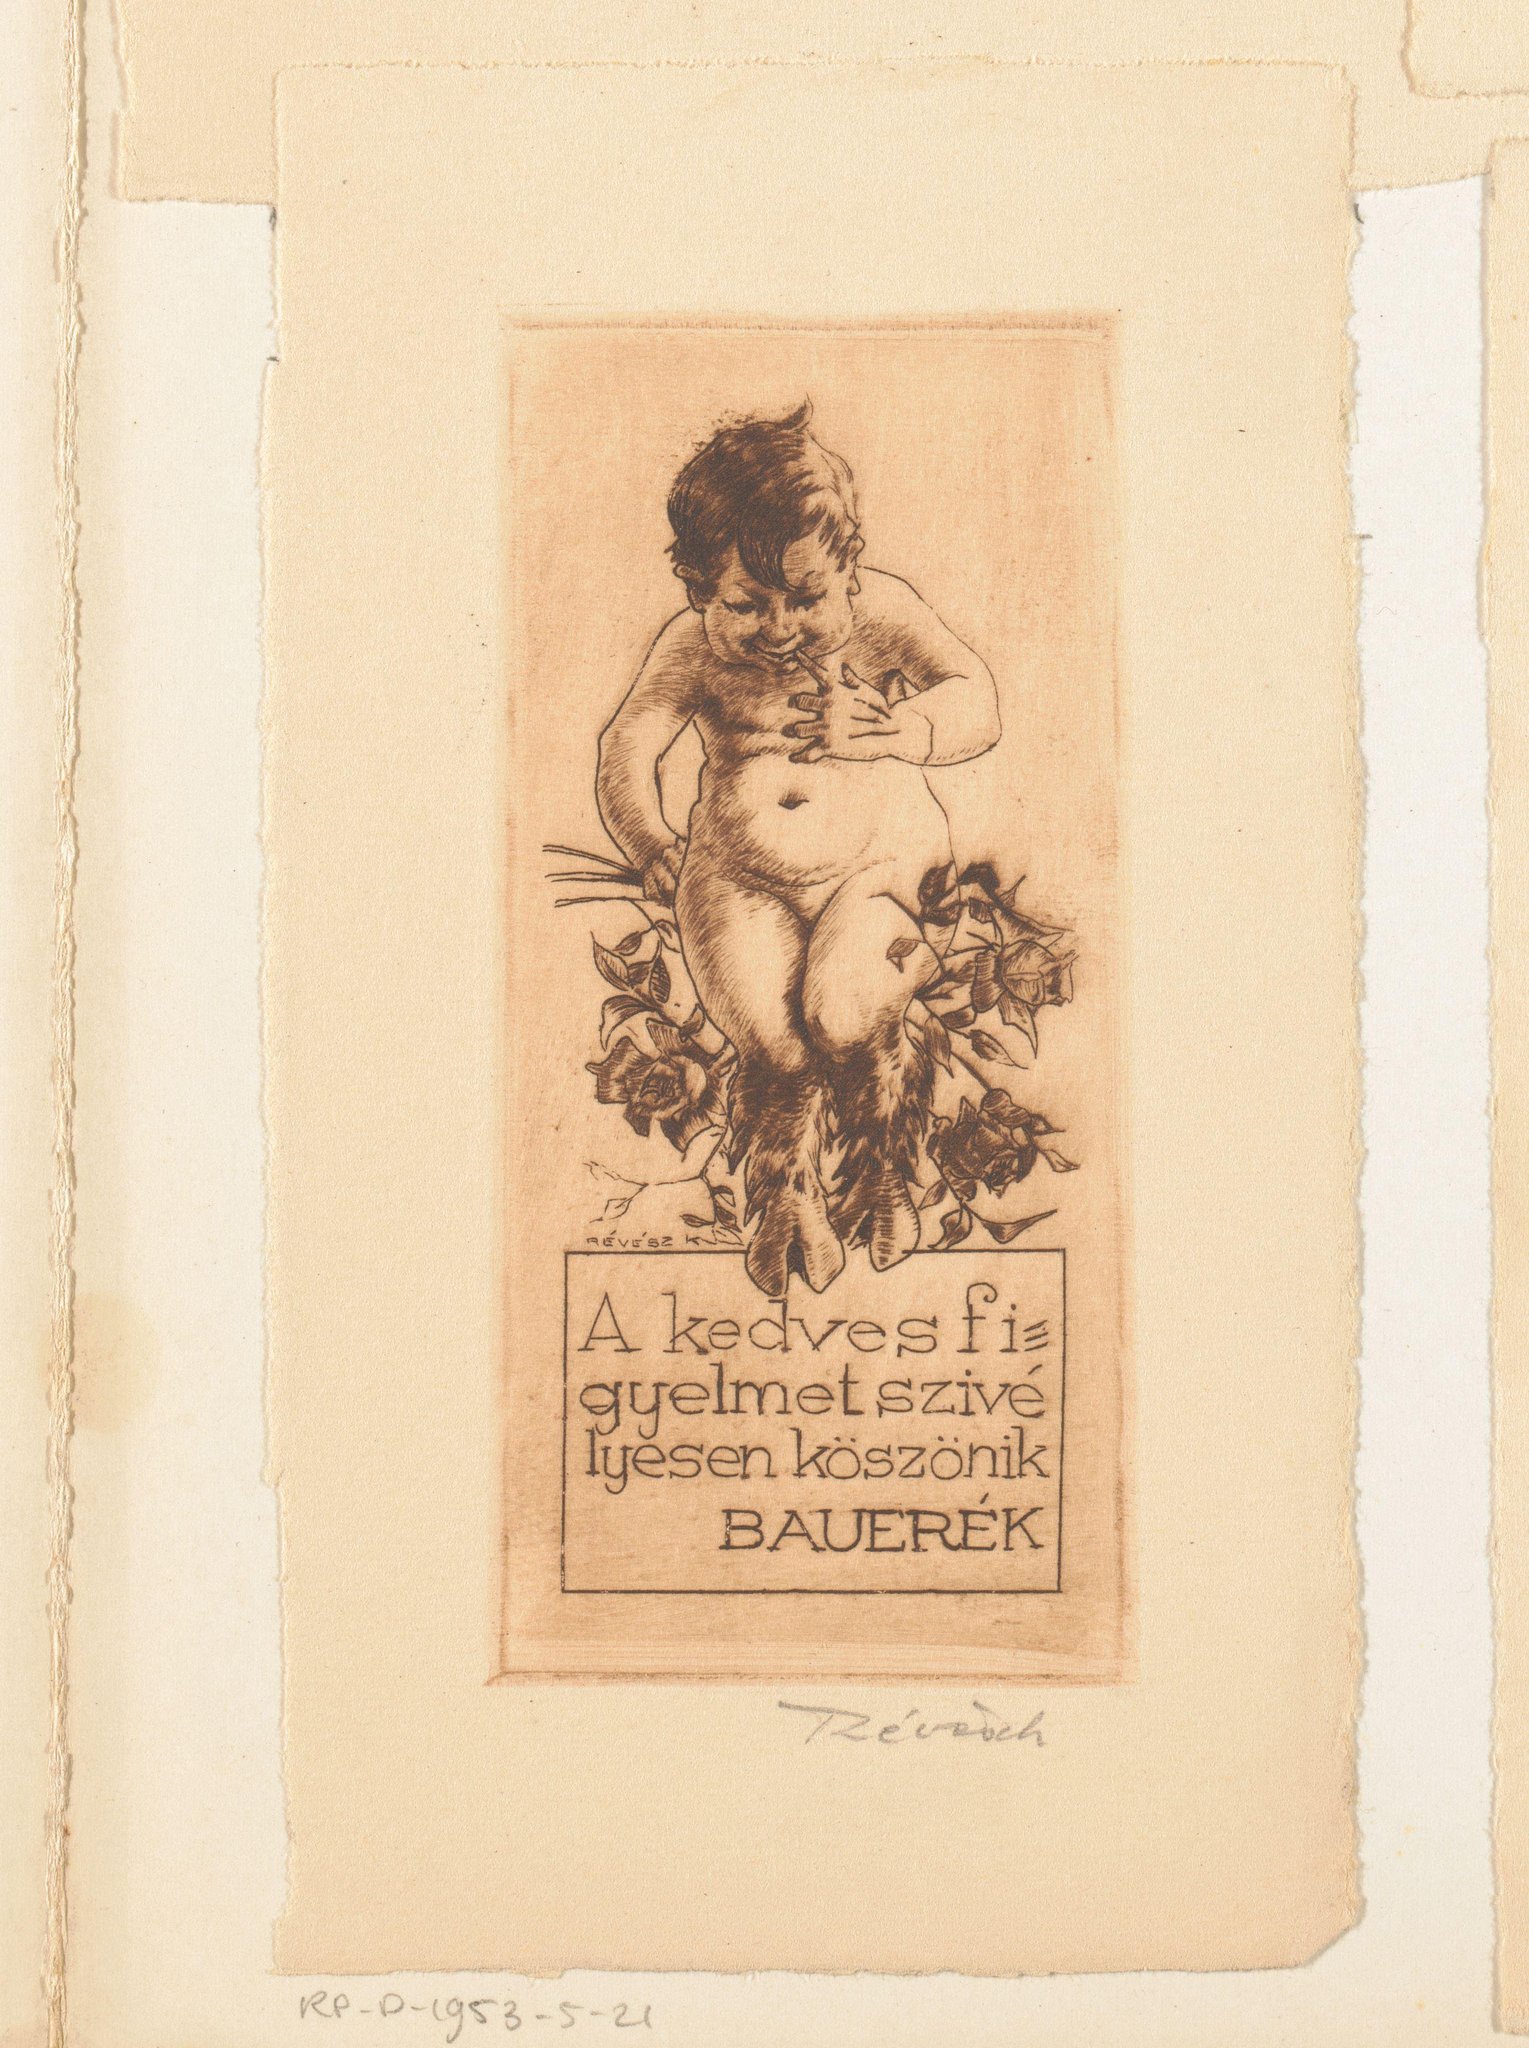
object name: acknowledgment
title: A kedves figyelmet szivé lyesen köszönik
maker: kornél révész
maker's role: print maker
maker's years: 1885-1944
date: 1935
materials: paper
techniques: drypoint, etching, intaglio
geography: budapest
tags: satyrs, fauns, sileni, toddler (male), flowers: rose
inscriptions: date: ‘Nr. 111/ 1935’, workshop stamp: ‘Fecit/ Révész Kornél/ Budapest’, signature: ‘Révész’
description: Ex libris maakt deel uit van omslag met 64 ex libris op 34 losse opzetvellen, een catalogus en een tekstblad.